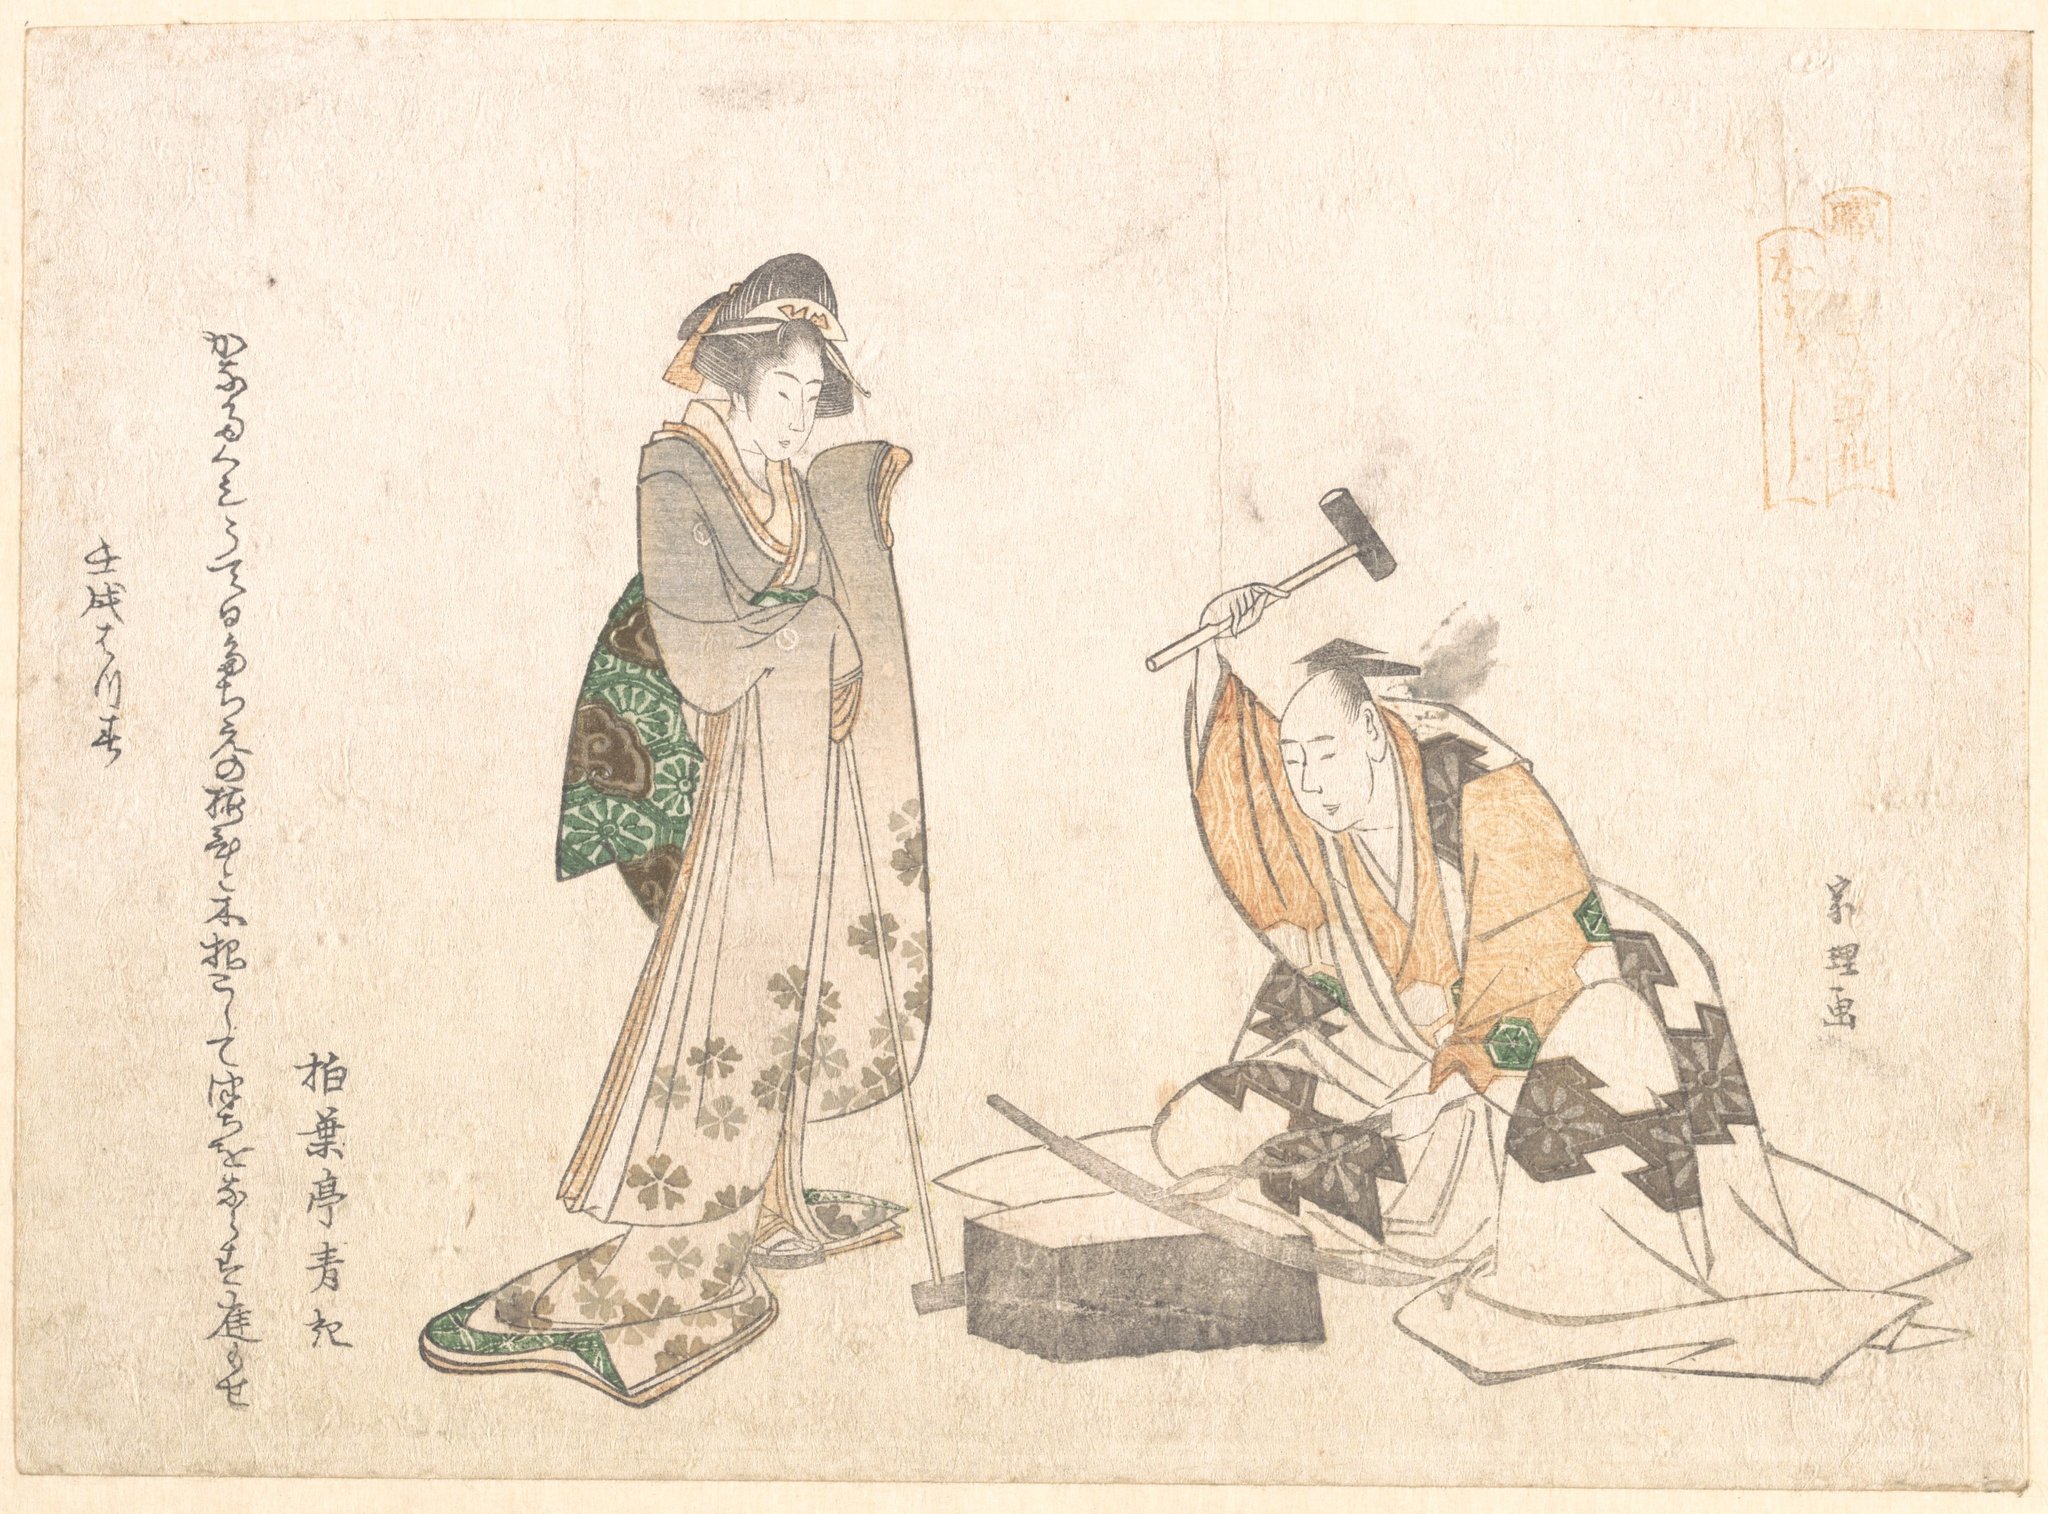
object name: print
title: The Swordsmith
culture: japanese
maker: katsushika hokusai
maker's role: artist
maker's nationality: japanese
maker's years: 1760-1849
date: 1802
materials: ink, paper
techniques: surimono, woodblock print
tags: men,women